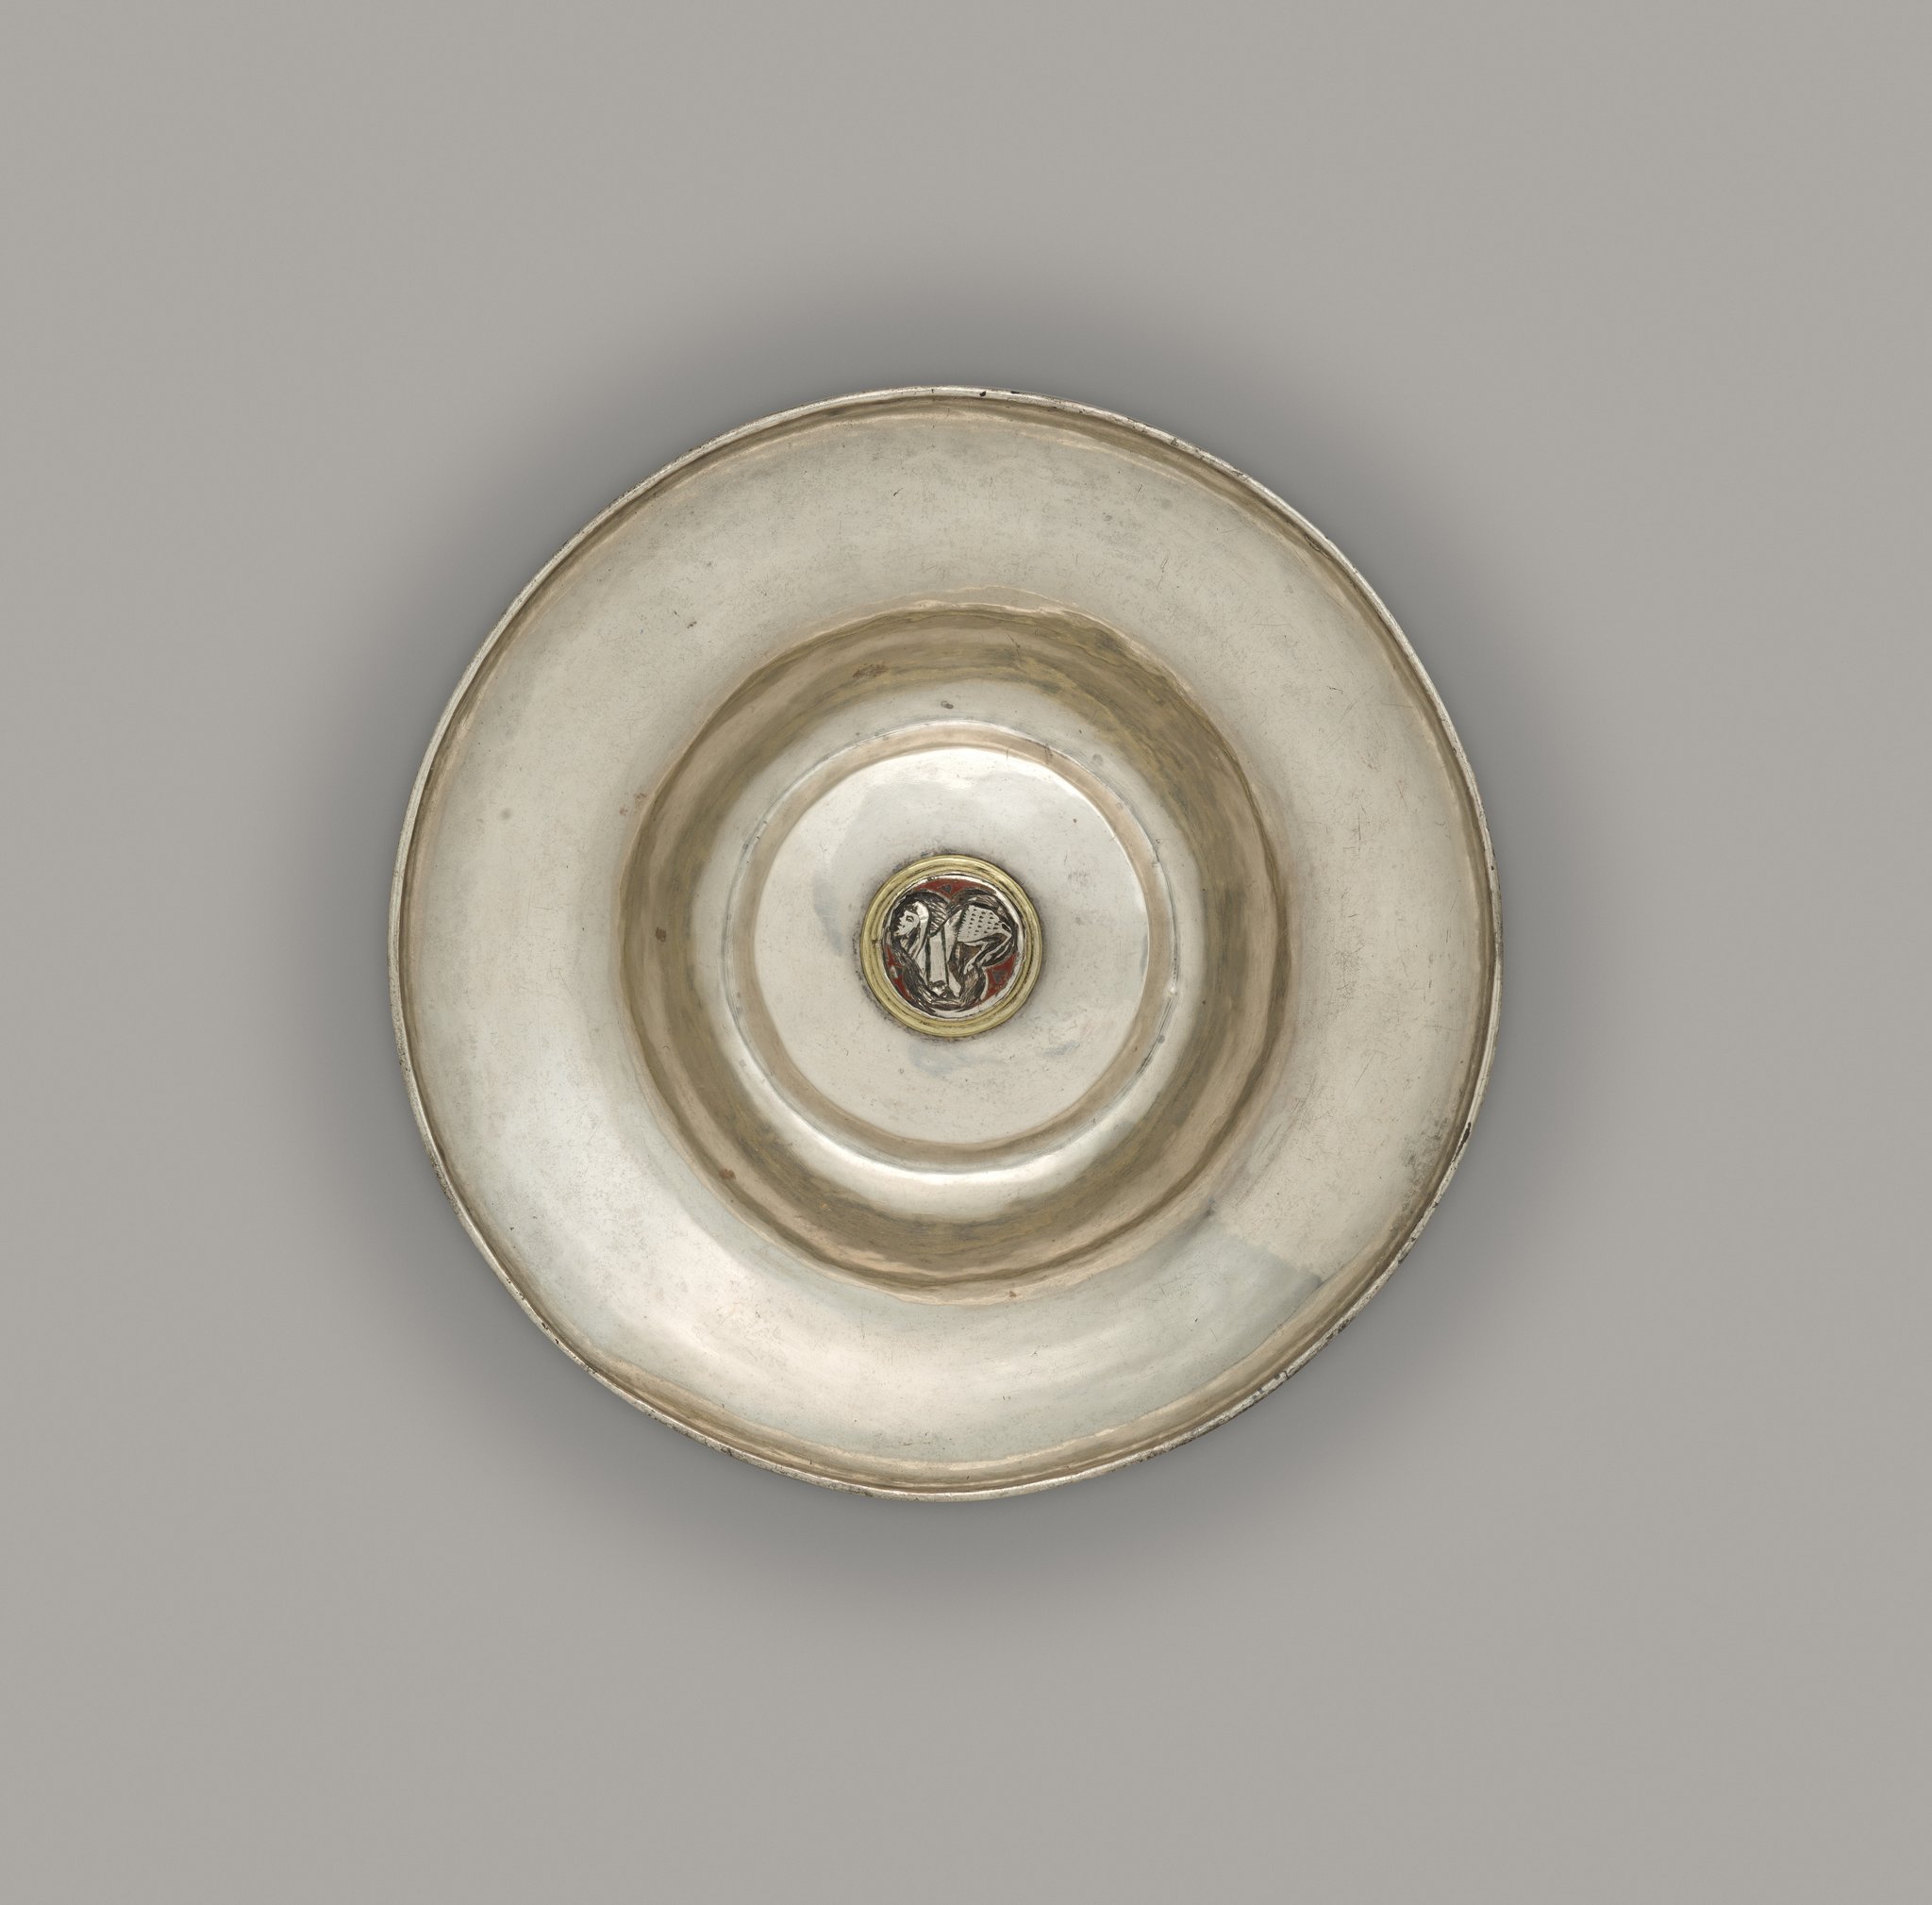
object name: drinking vessel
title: Drinking Vessel (Hanap; one of a pair)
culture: french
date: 1320-1360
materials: enamel, silver, silver gilt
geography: france